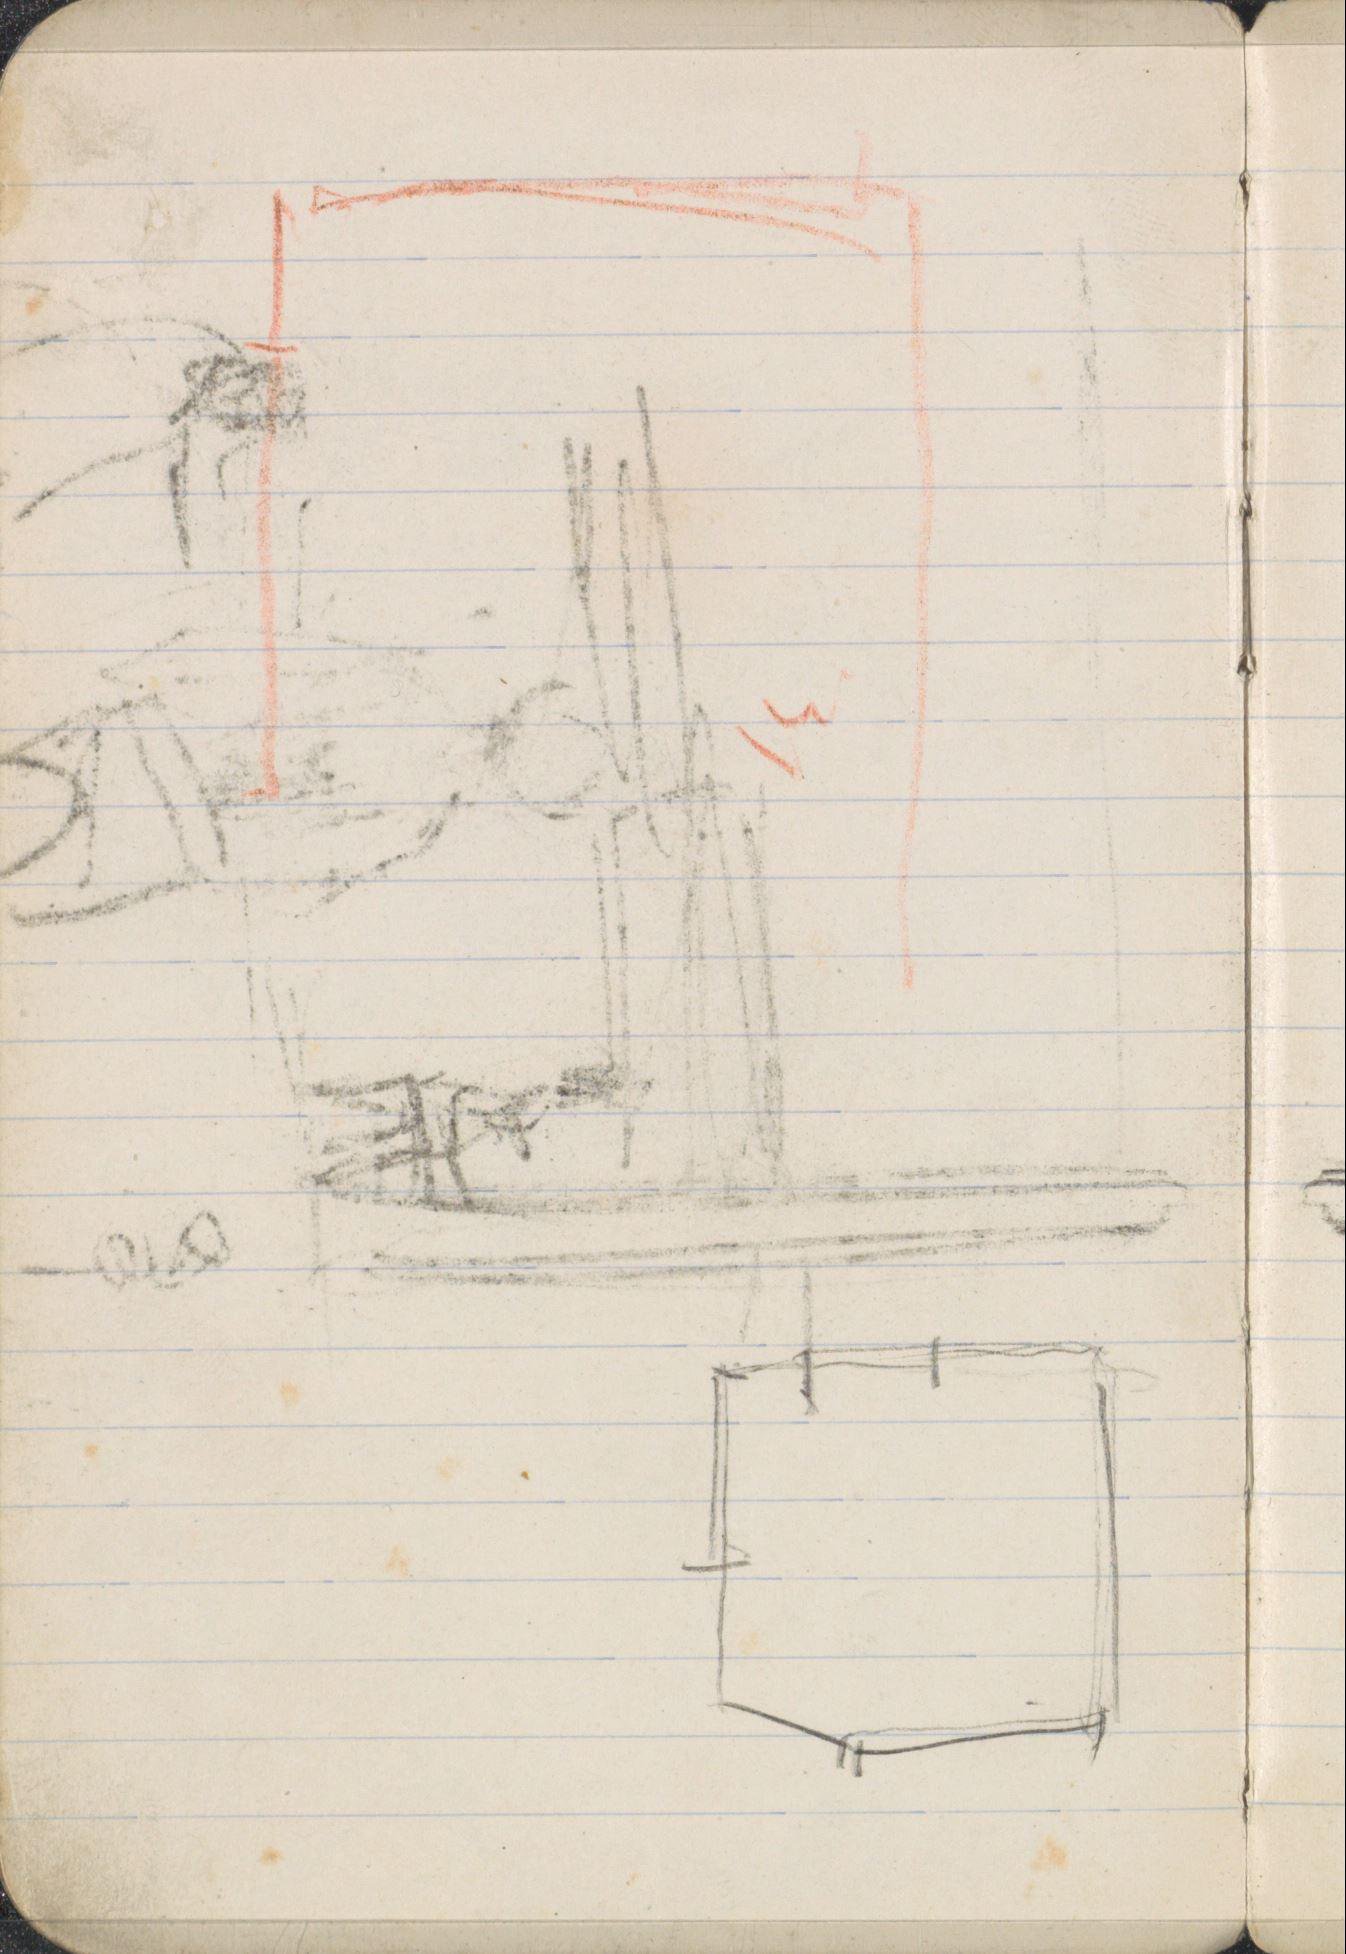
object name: sketchbook leaf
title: Studieblad, mogelijk met plattegronden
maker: george hendrik breitner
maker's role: draughtsman, painter, print maker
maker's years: 1857-1923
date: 1896-1897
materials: chalk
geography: amsterdam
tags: plan ~ architecture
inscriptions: annotation: ‘14’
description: Pagina 15 uit een schetsboek met 39 bladen.